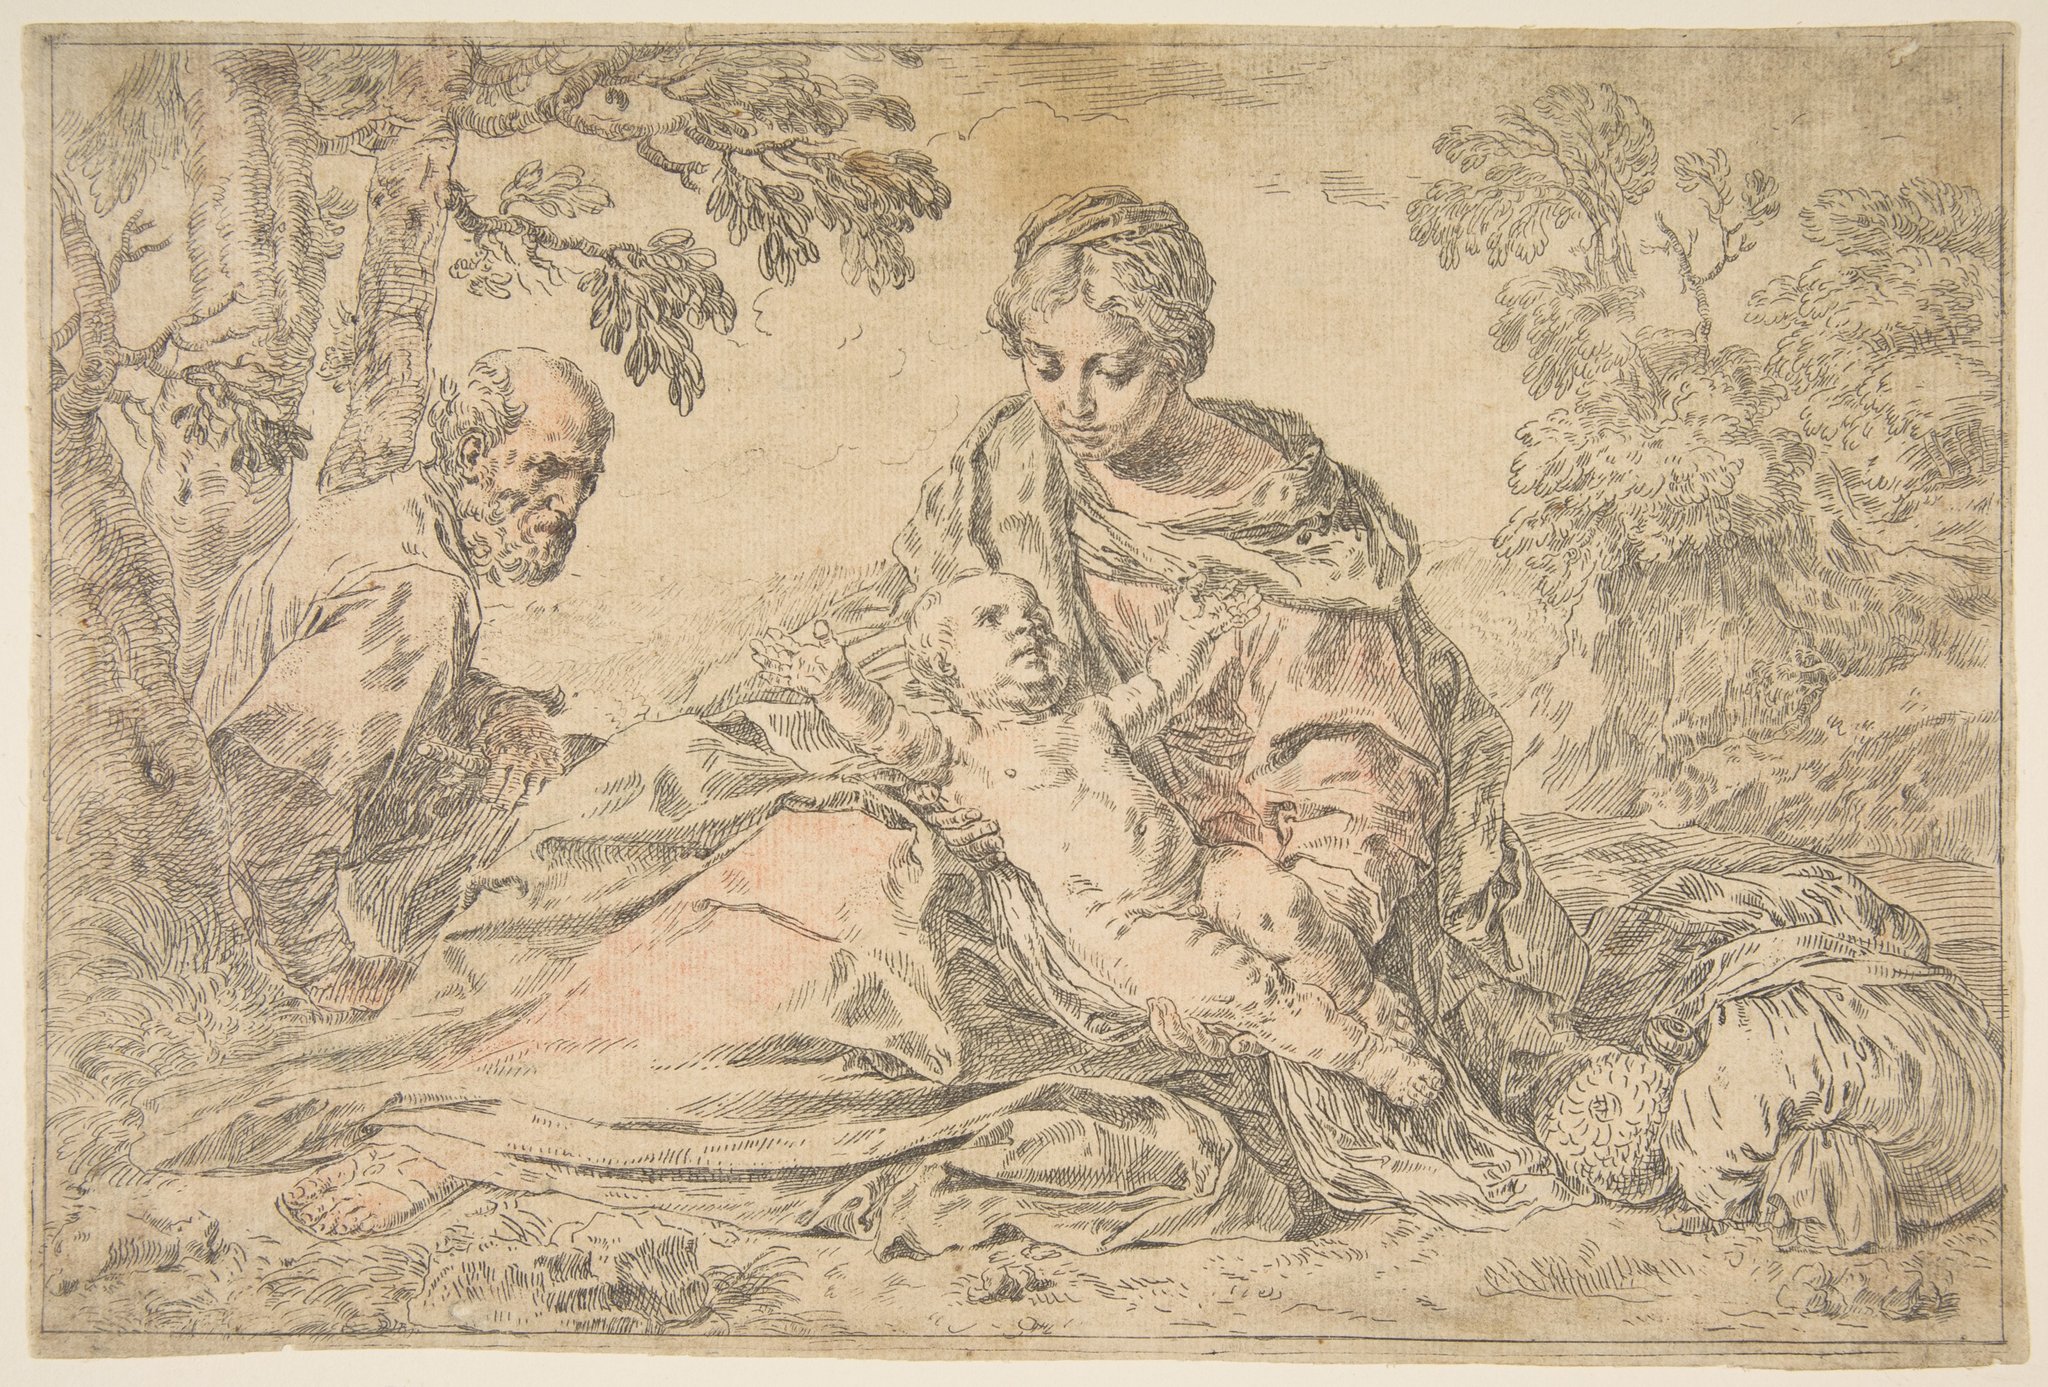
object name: print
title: Rest on the flight into Egypt, Mary holding the infant Christ with St. Joseph at left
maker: simone cantarini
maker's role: artist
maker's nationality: italian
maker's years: 1612-1648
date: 1640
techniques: etching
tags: christ,saint joseph,virgin mary